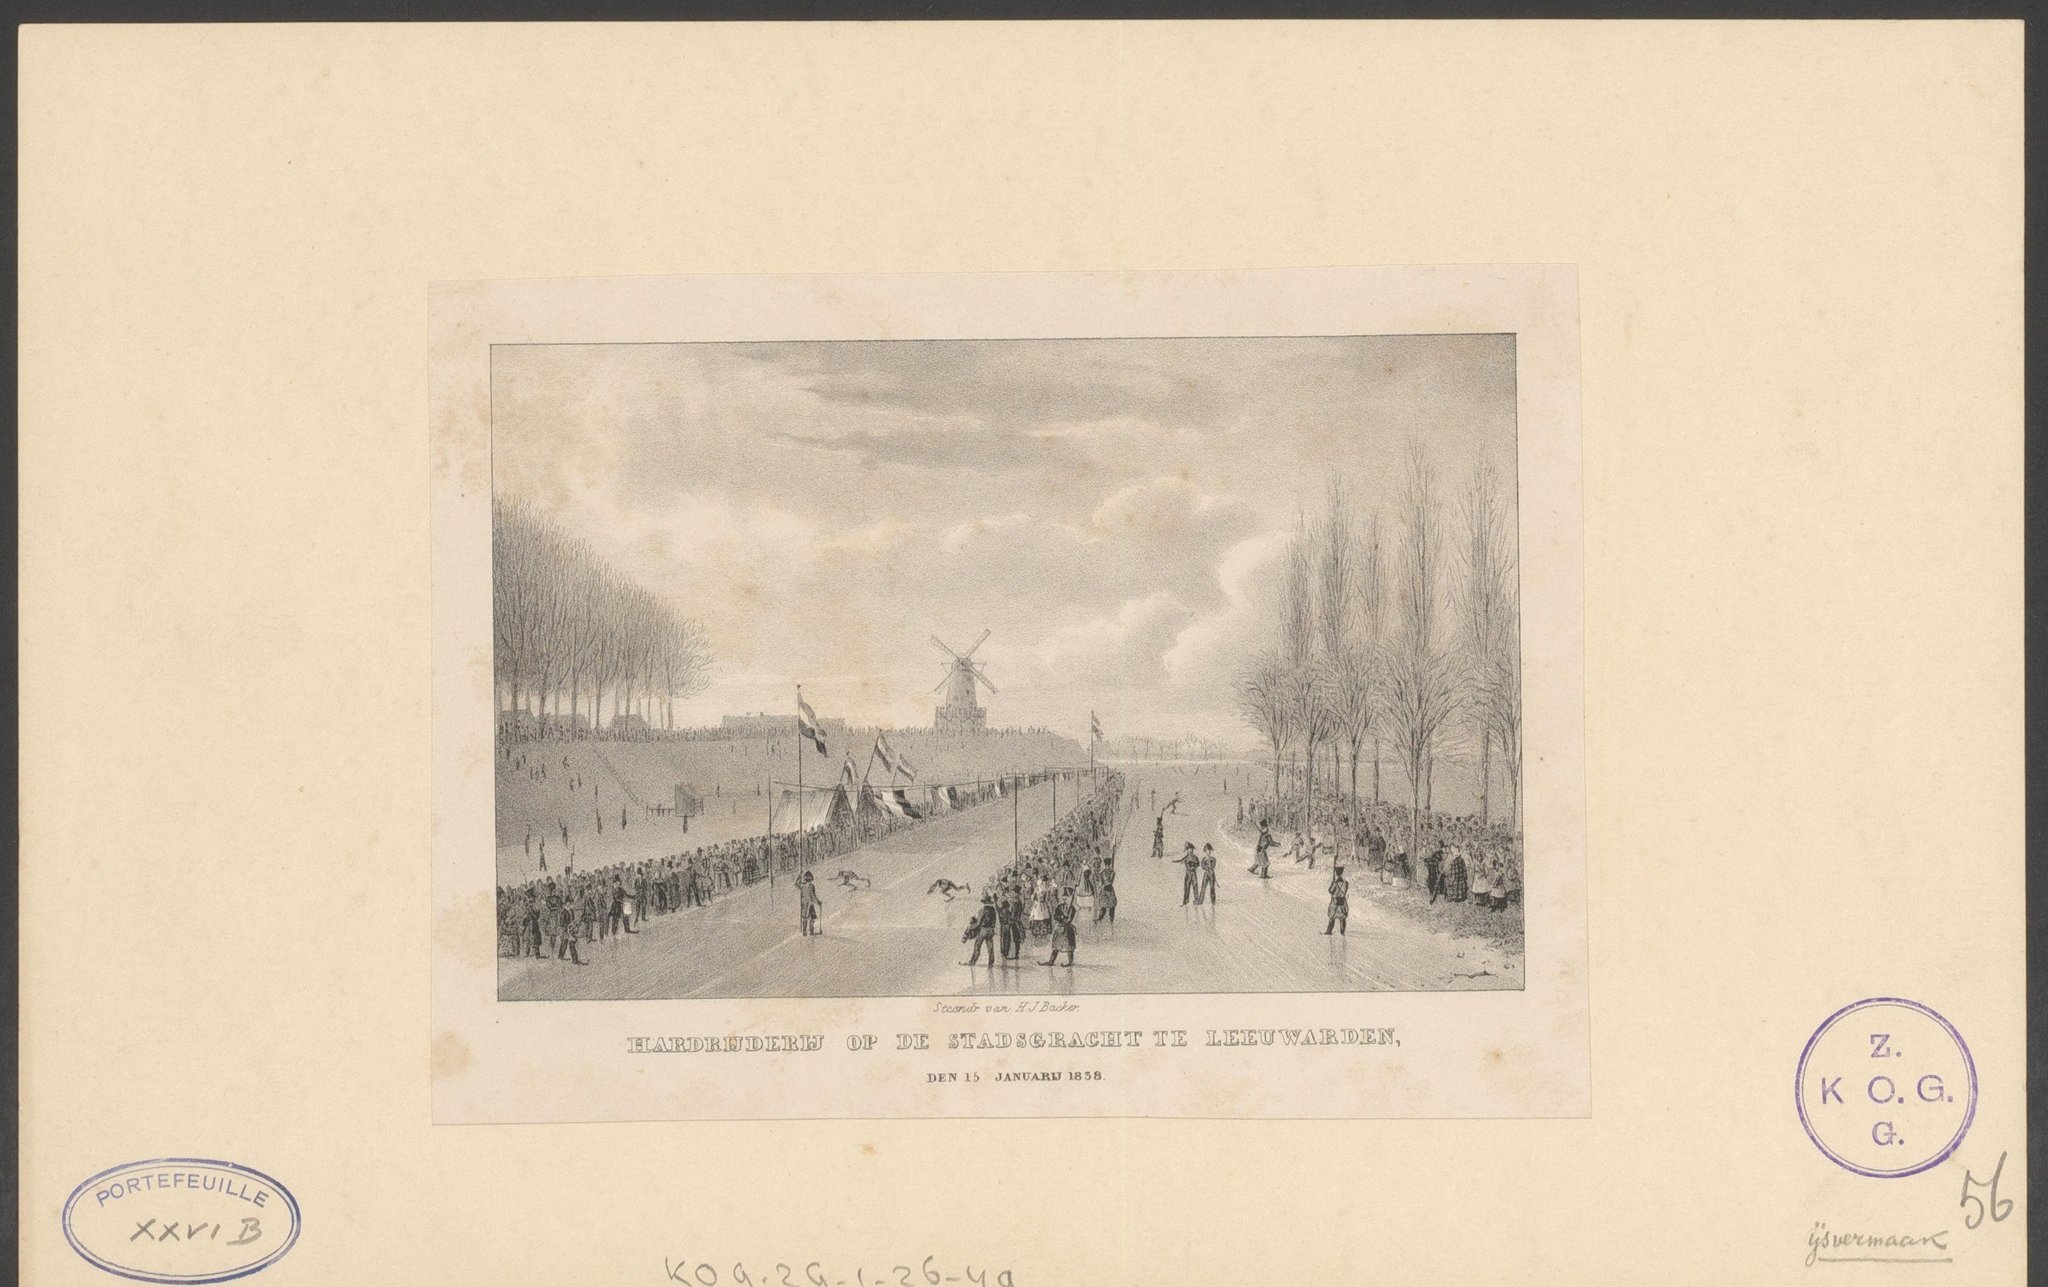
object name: print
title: Hardrijderij op de Stadsgracht te Leeuwarden, den 15 januarij 1838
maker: hilmar johannes backer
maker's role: print maker, printer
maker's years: 1804-1845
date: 1838-1845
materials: paper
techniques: lithograph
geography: netherlands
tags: frost, freezing weather, skates (winter sports) (+ the contest (sports, games, etc.))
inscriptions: collector's mark: Lugt 1641, collector's mark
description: Schaatswedstrijd gehouden op de Stadsgracht te Leeuwarden op 15 januari 1838. Onderwerpsrubrieken binnen de Atlas Zeden en Gewoonten: Spel en Vermaak; IJsvermaak, IJsschuiten ijsrijwiel.